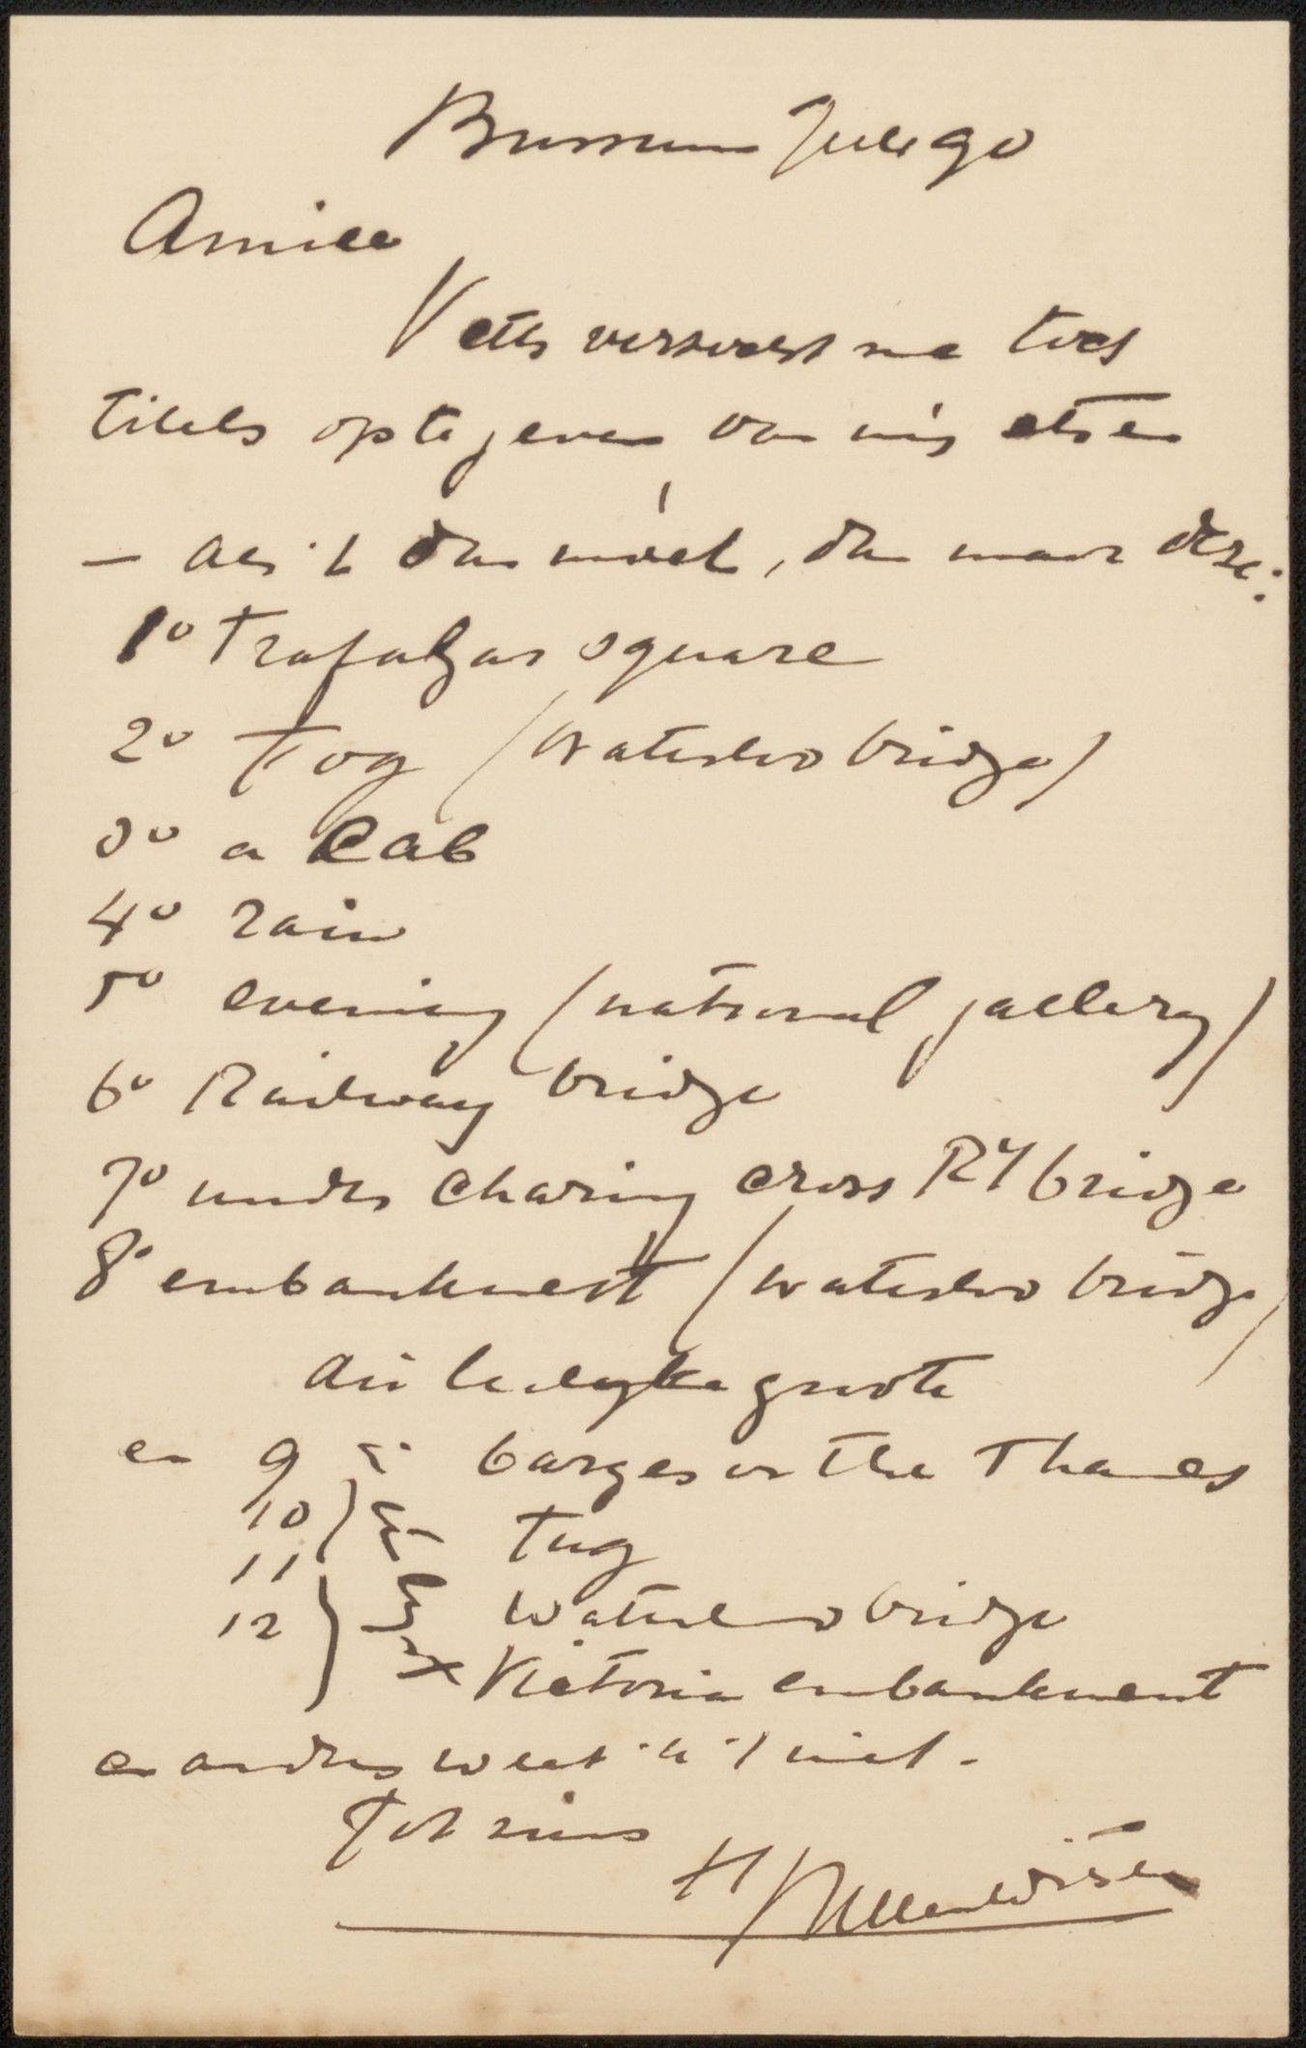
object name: letter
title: Brief aan Philip Zilcken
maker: willem witsen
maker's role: draughtsman, painter, print maker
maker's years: 1860-1923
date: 1807-1890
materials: ink, paper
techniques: pen, writing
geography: bussum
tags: dordrecht, amsterdam, print maker, designer, jan veth, the hague, painter, draughtsman, philip zilcken, the graphic arts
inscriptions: collector's mark: ‘RPK’, watermark